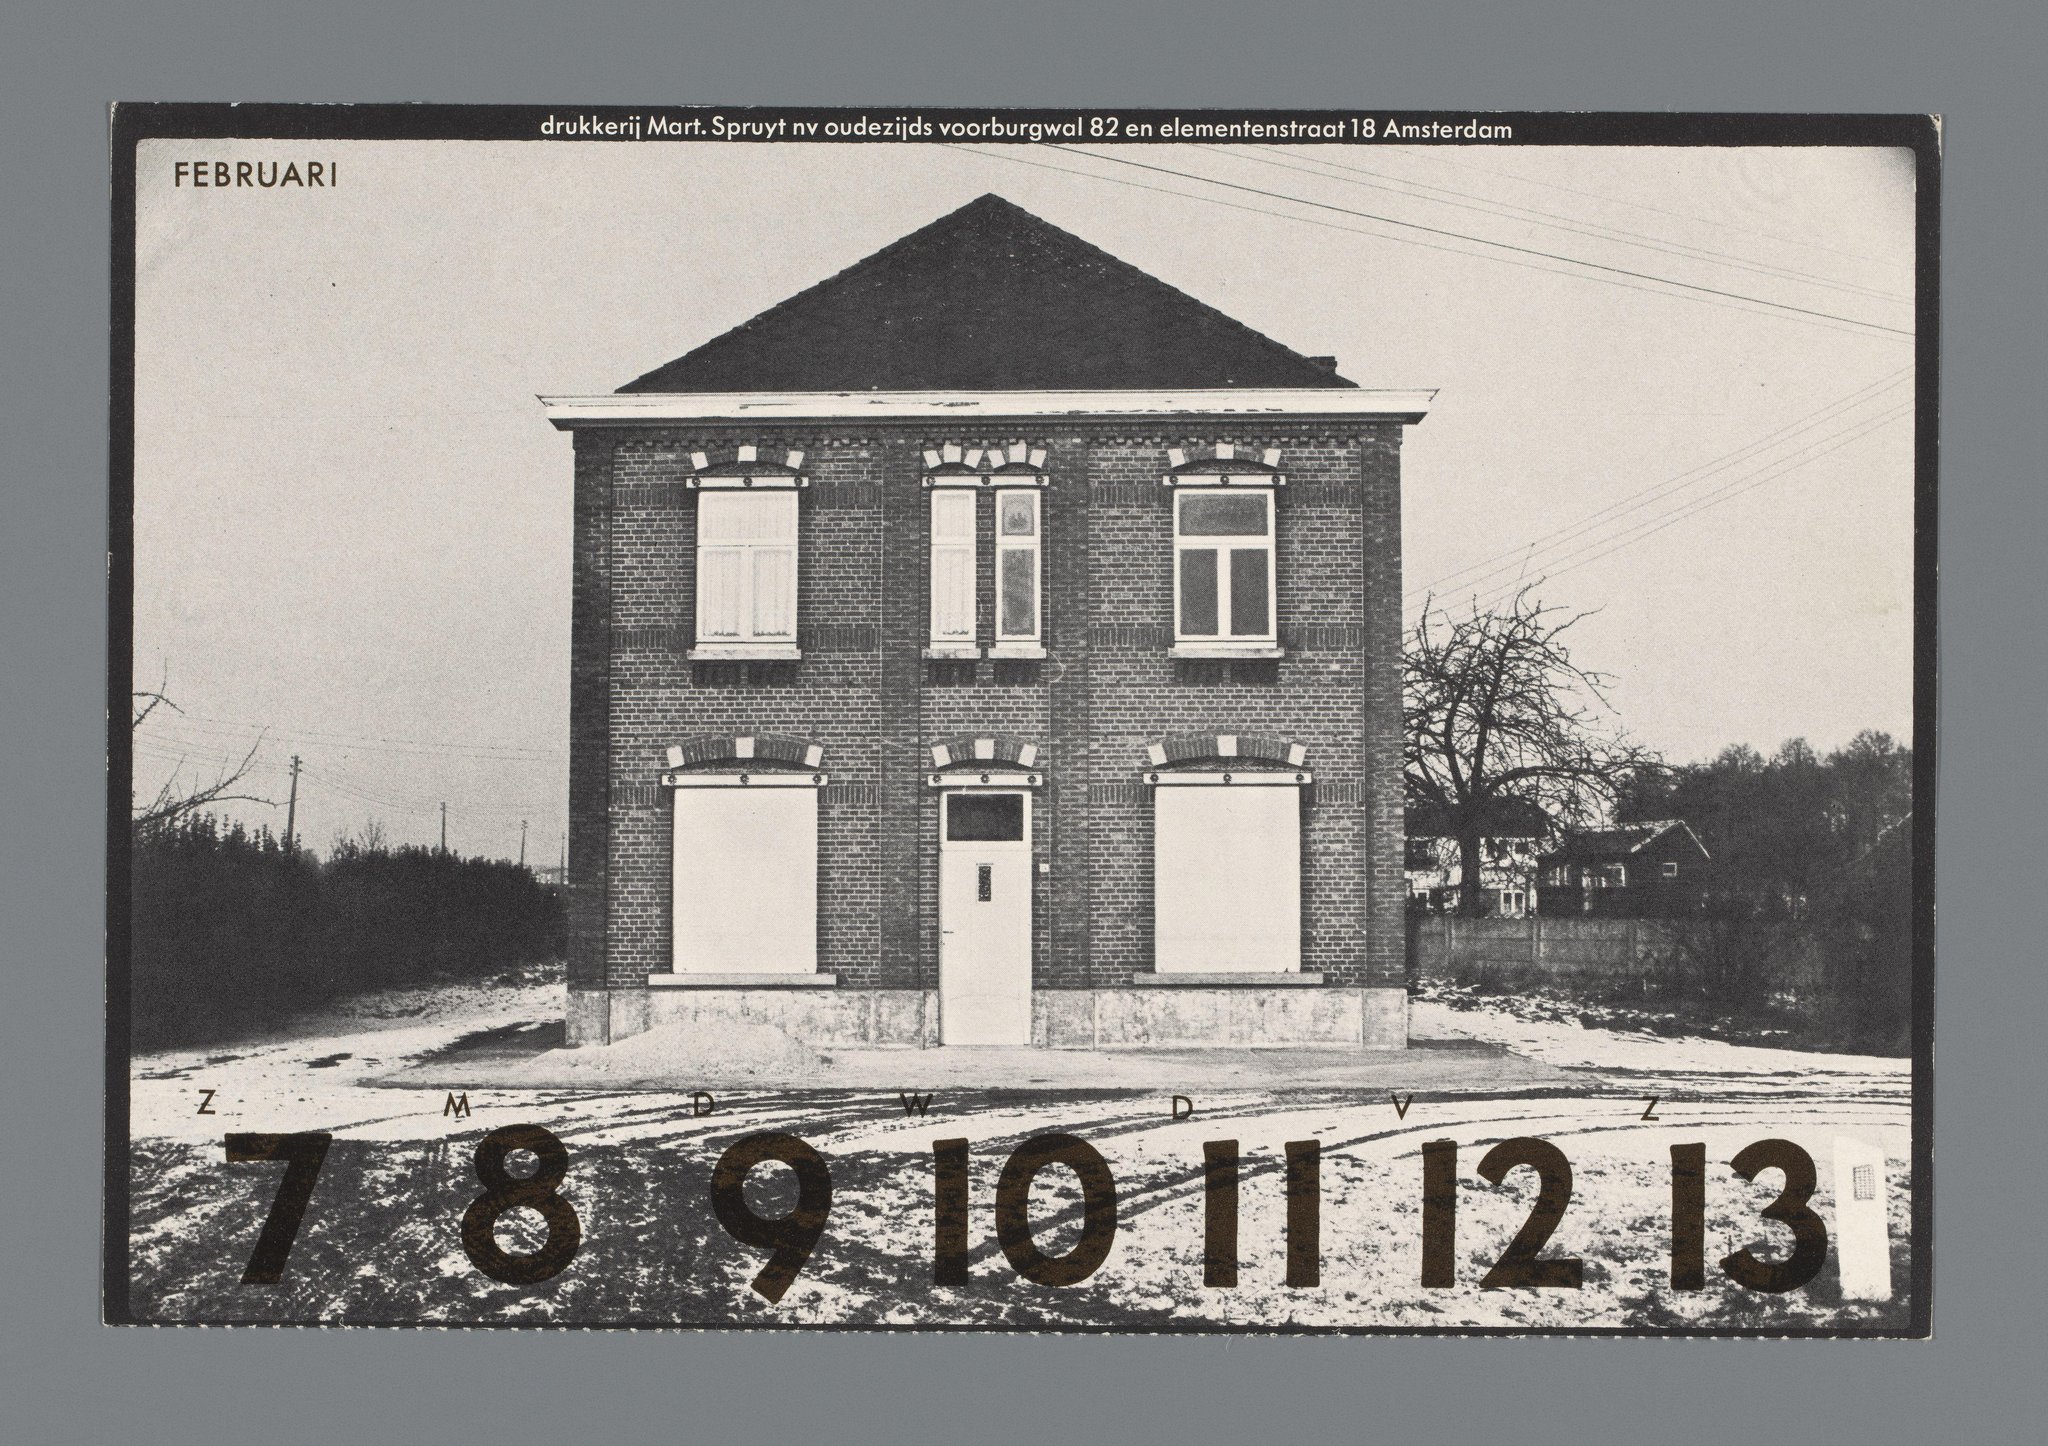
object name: photograph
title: België. Huizen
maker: Anonymous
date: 1900-1950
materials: paper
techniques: offset printed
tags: belgium